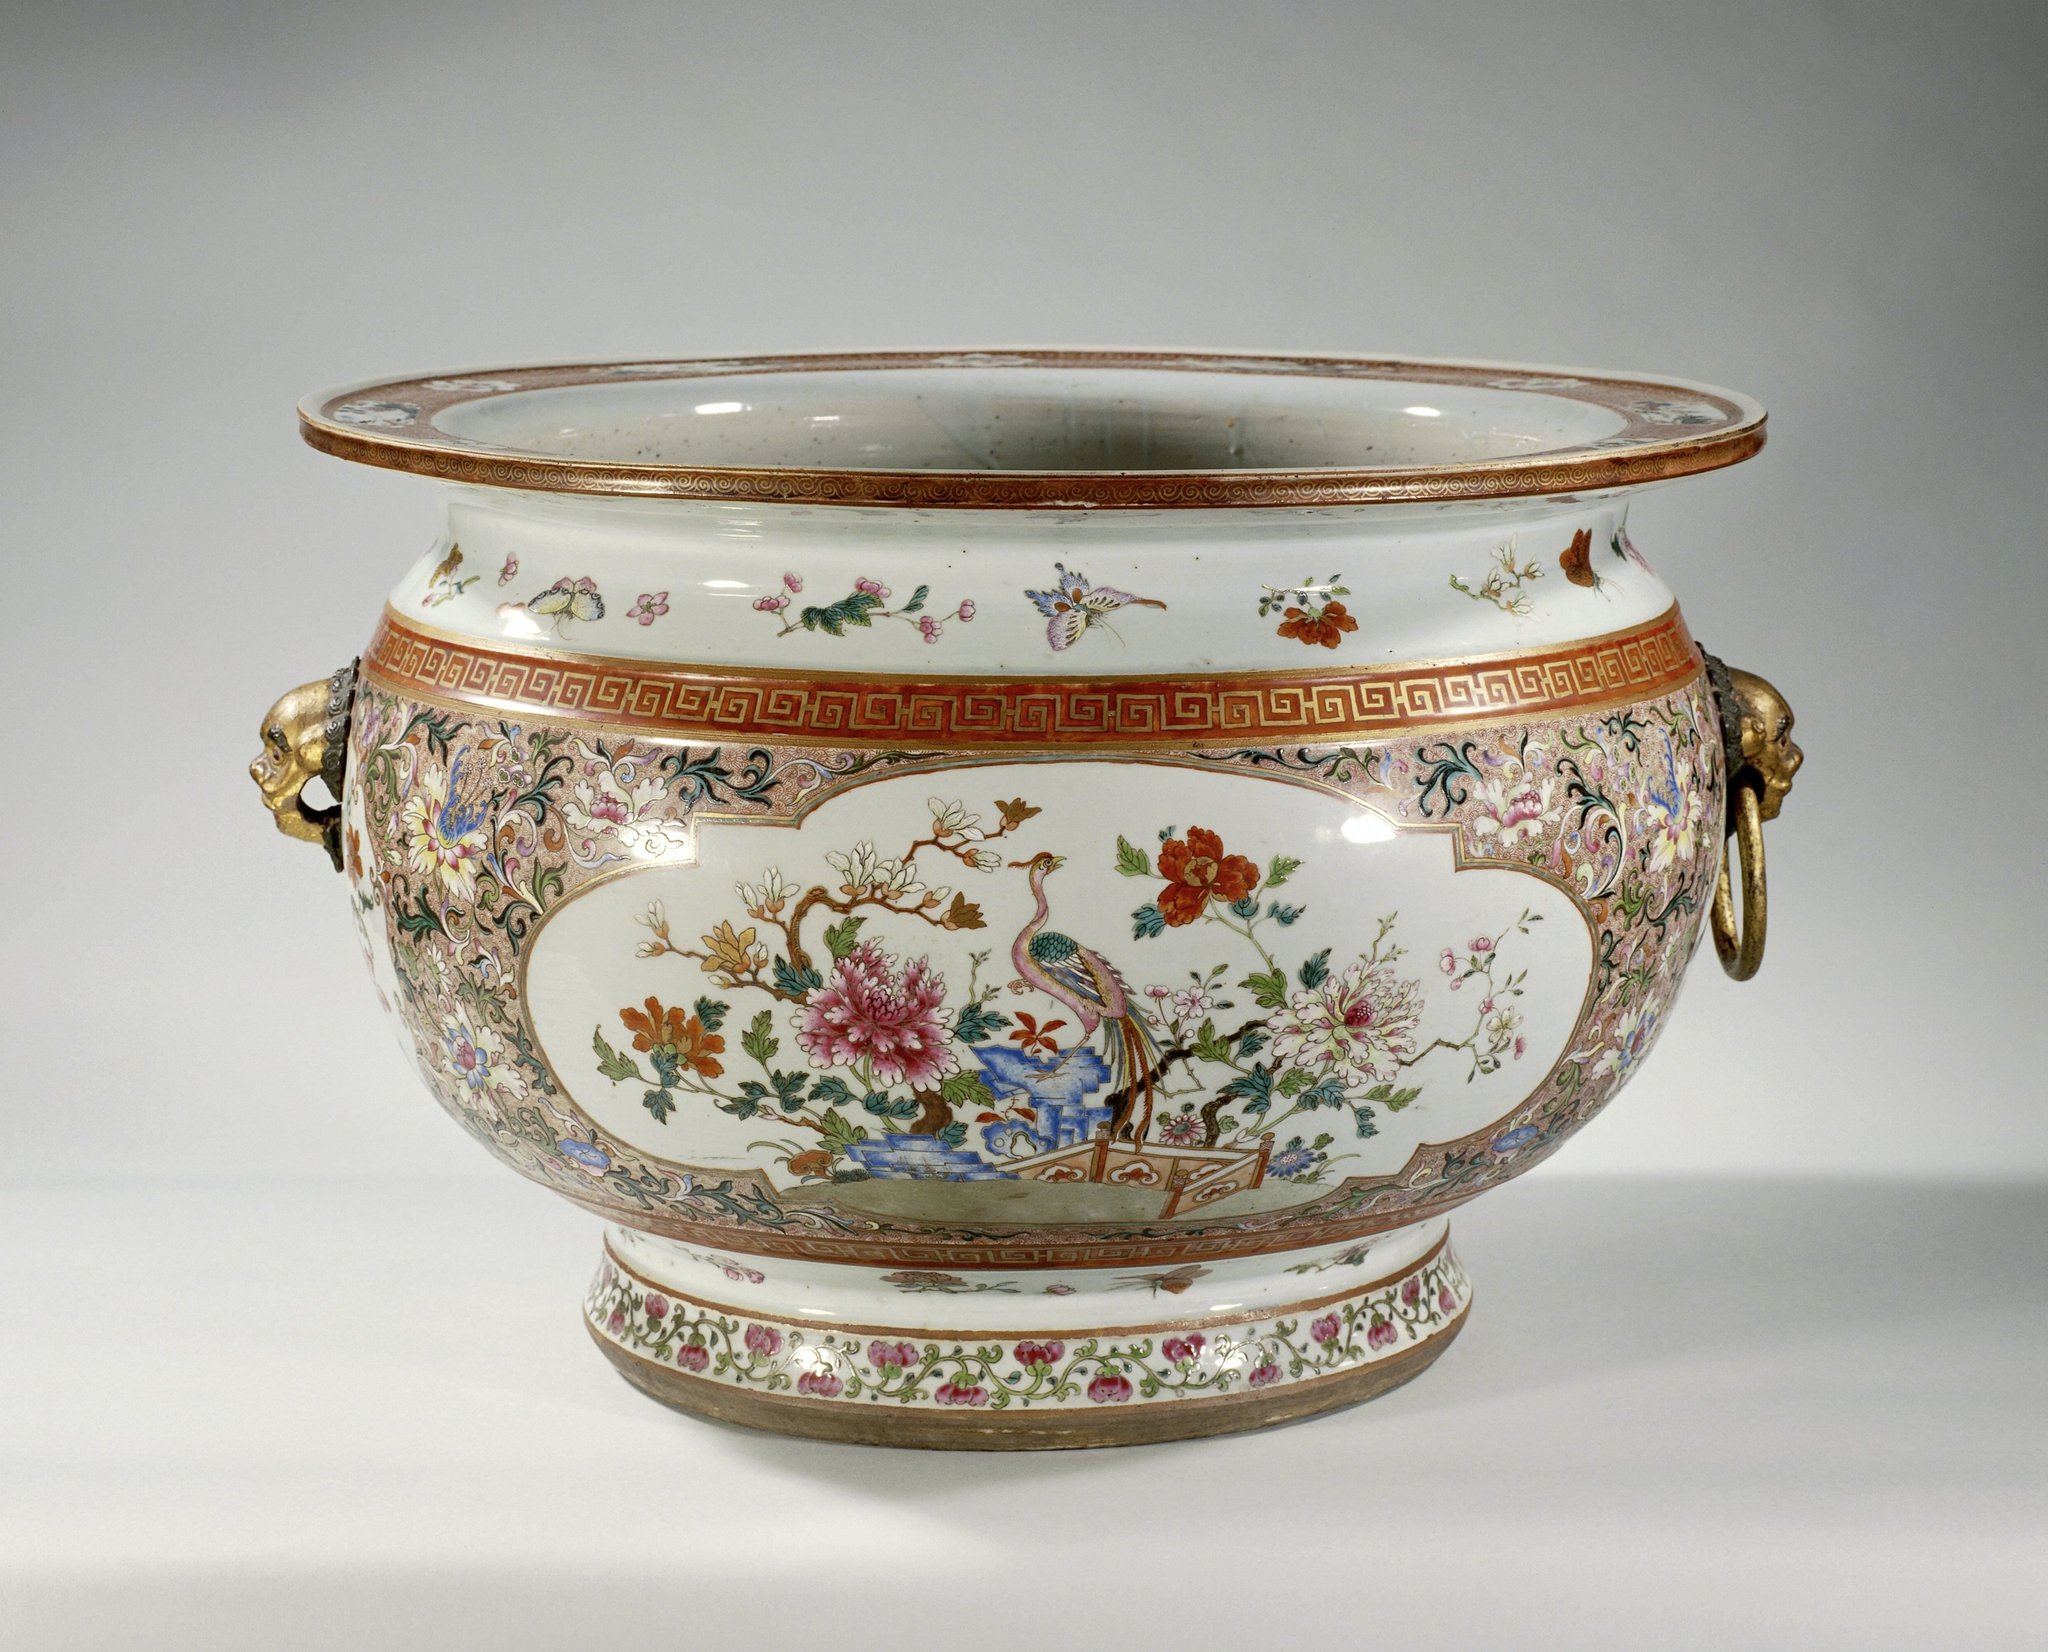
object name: viskom, vissenkom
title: Fish bowl with floral scrolls, flowering plants, birds and insects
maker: Anonymous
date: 1740-1760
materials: glaze, gold, paint, porcelain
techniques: firing, gilding, turning, vitrification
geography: china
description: Fish bowl. Porcelain, enamel colours and gold over the glaze. China, c. 1740 - 1760. This bowl belonged to the sinologist Jean Theodore Royer (1737 - 1807) of The Hague. Royer studied Chinese language and culture; he amassed a vast collection of Chinese artefacts and art.